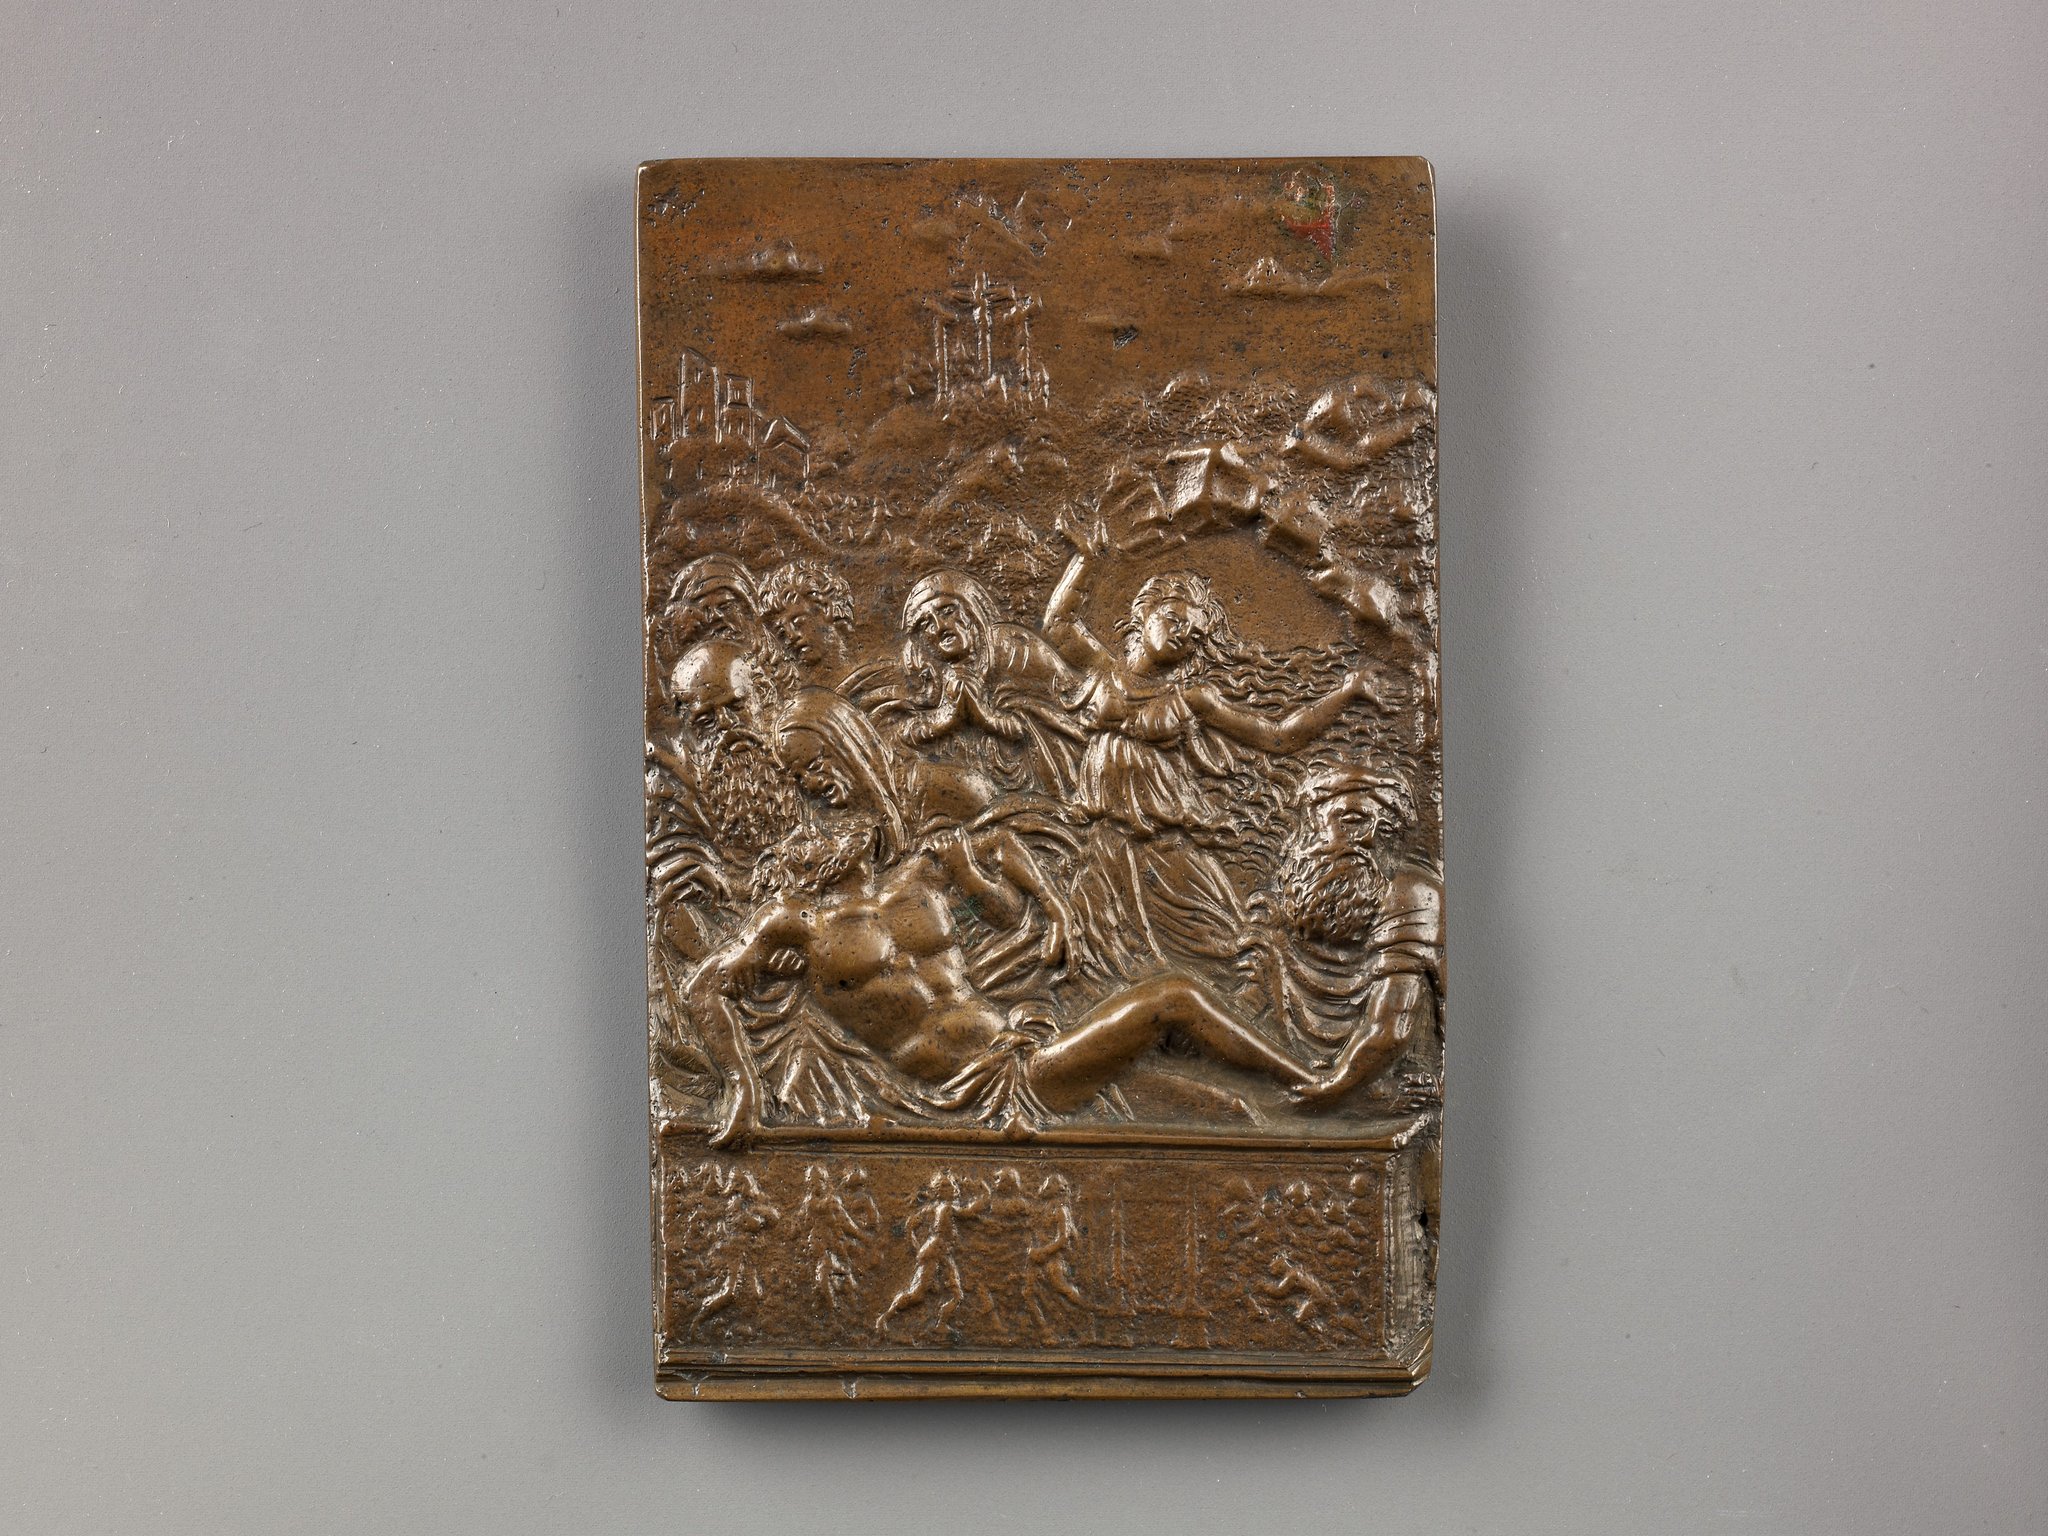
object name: plaquette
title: Entombment of Christ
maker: moderno (galeazzo mondella)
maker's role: artist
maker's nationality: italian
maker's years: 1467-1528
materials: copper alloy, patina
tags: christ,virgin mary,entombment